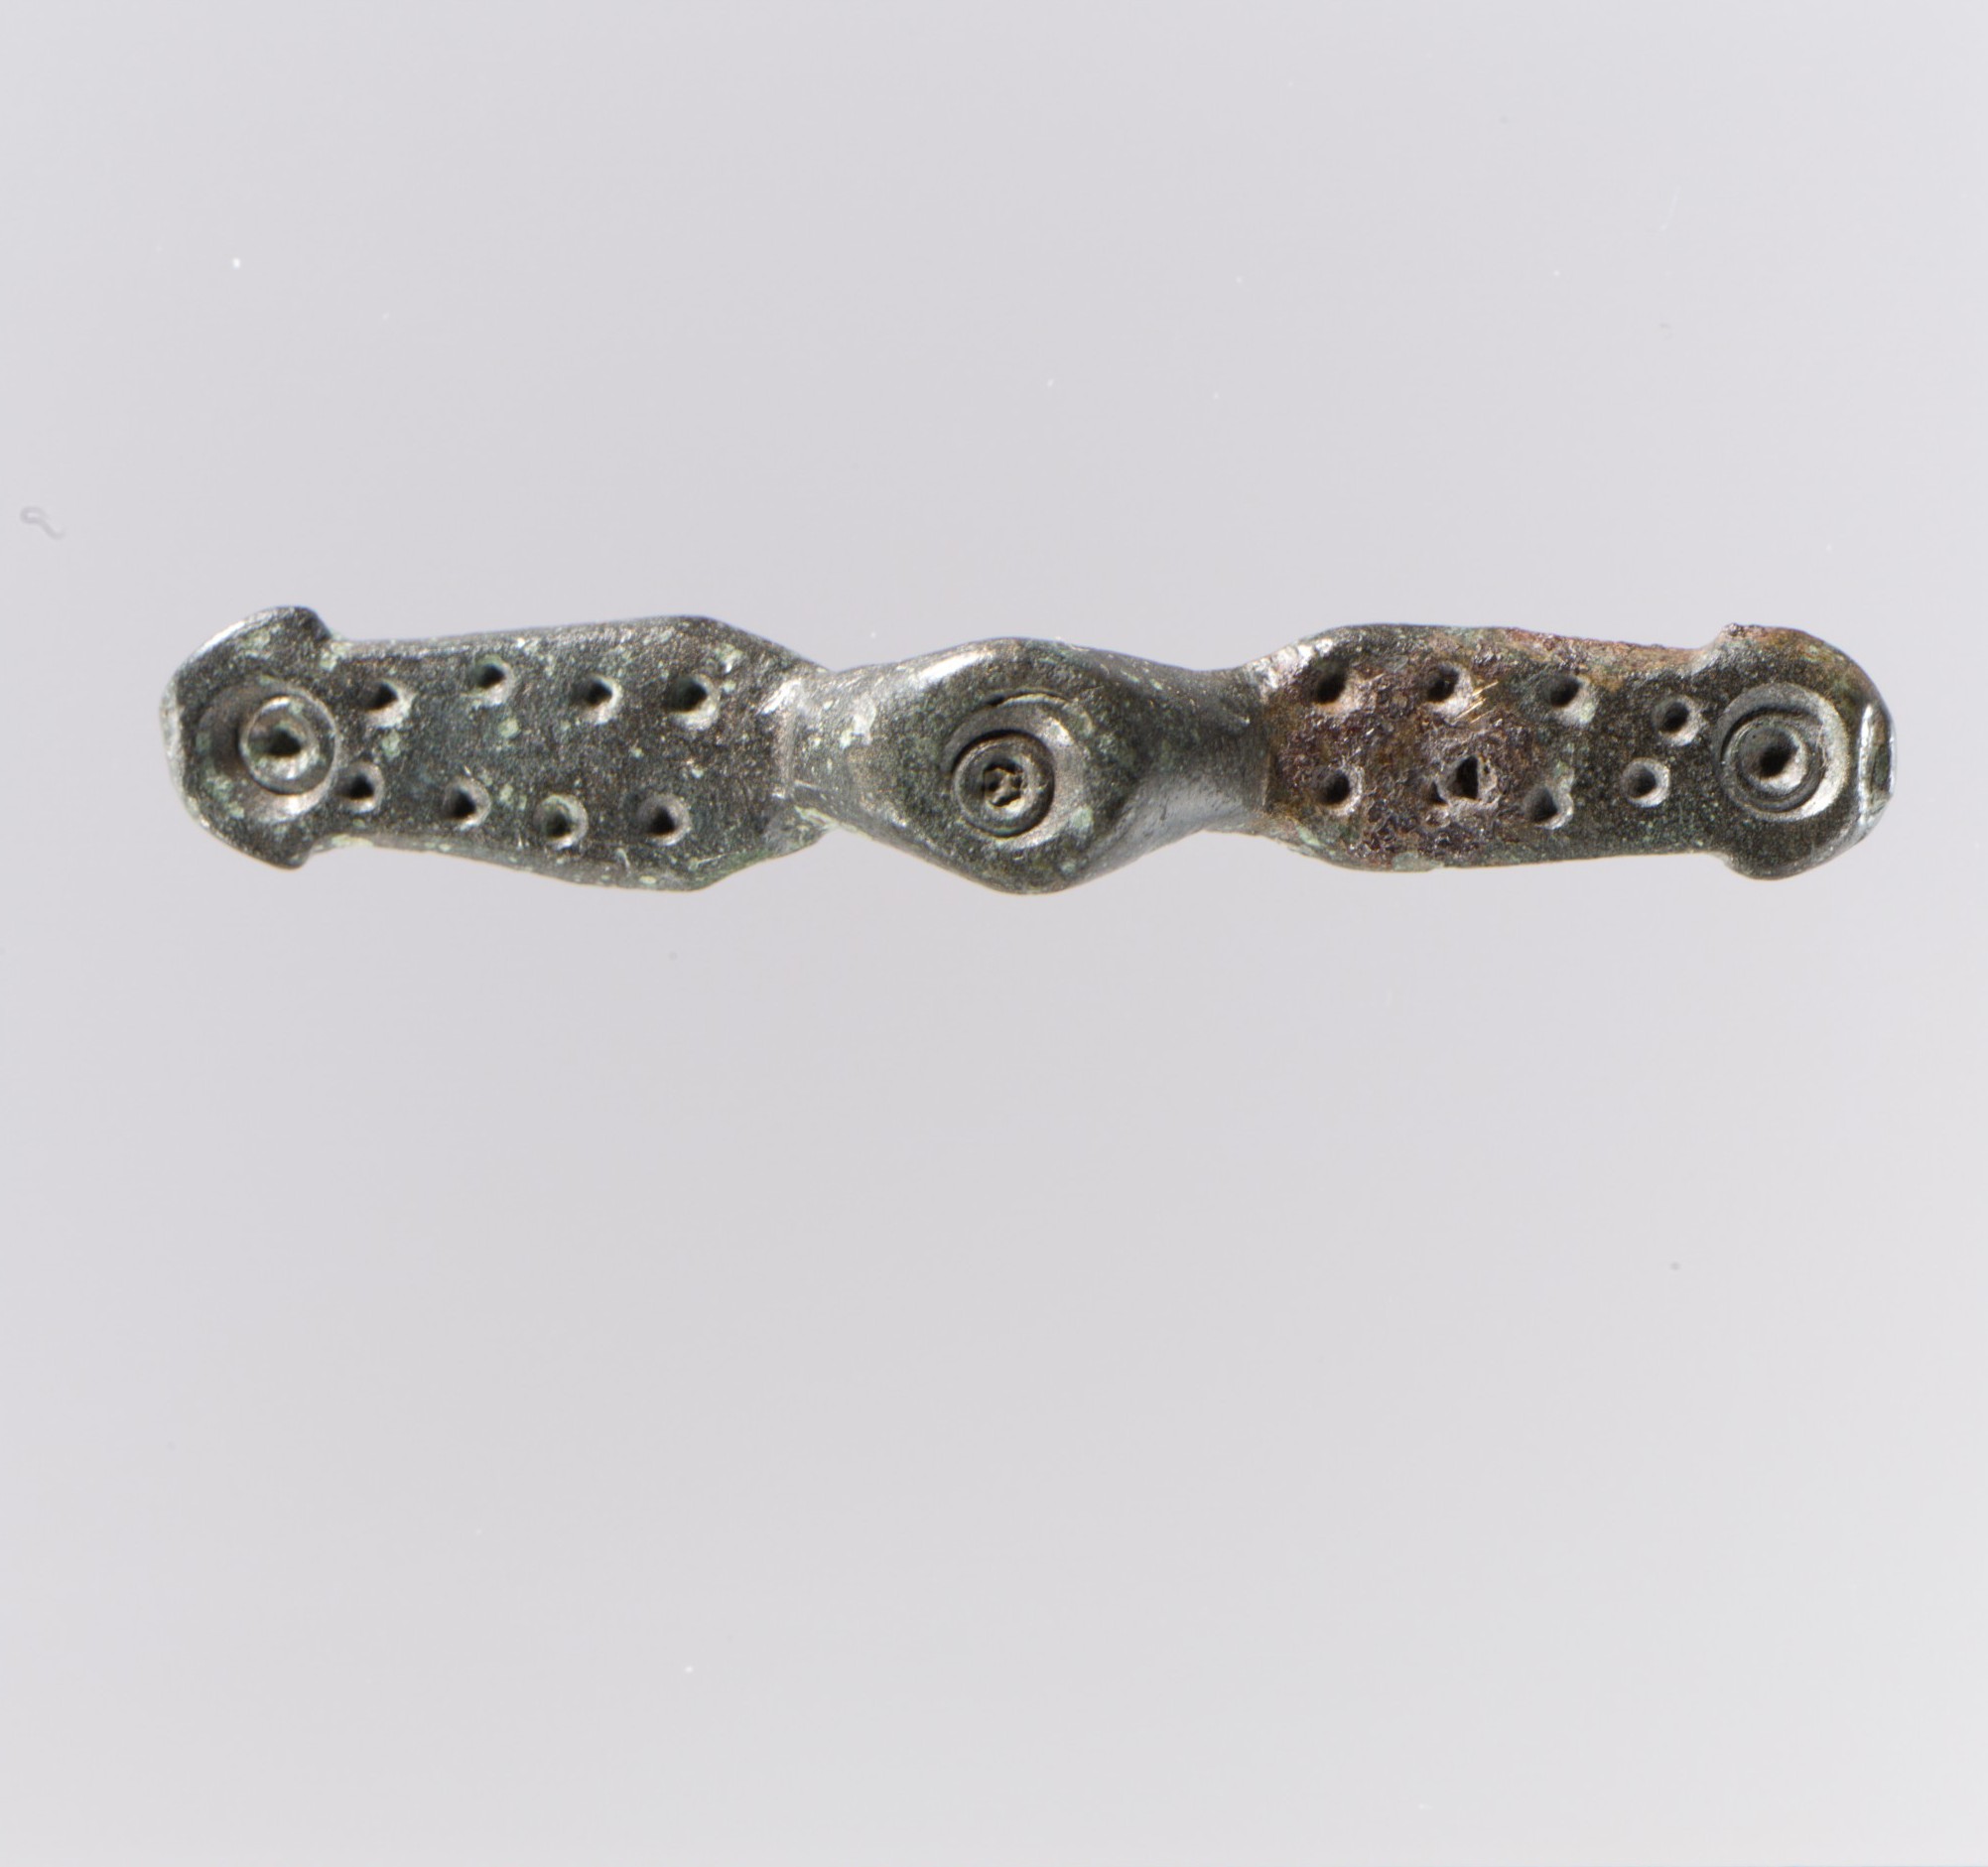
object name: brooch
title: Equal-Arm Brooch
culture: frankish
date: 601-800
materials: copper alloy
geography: northern france